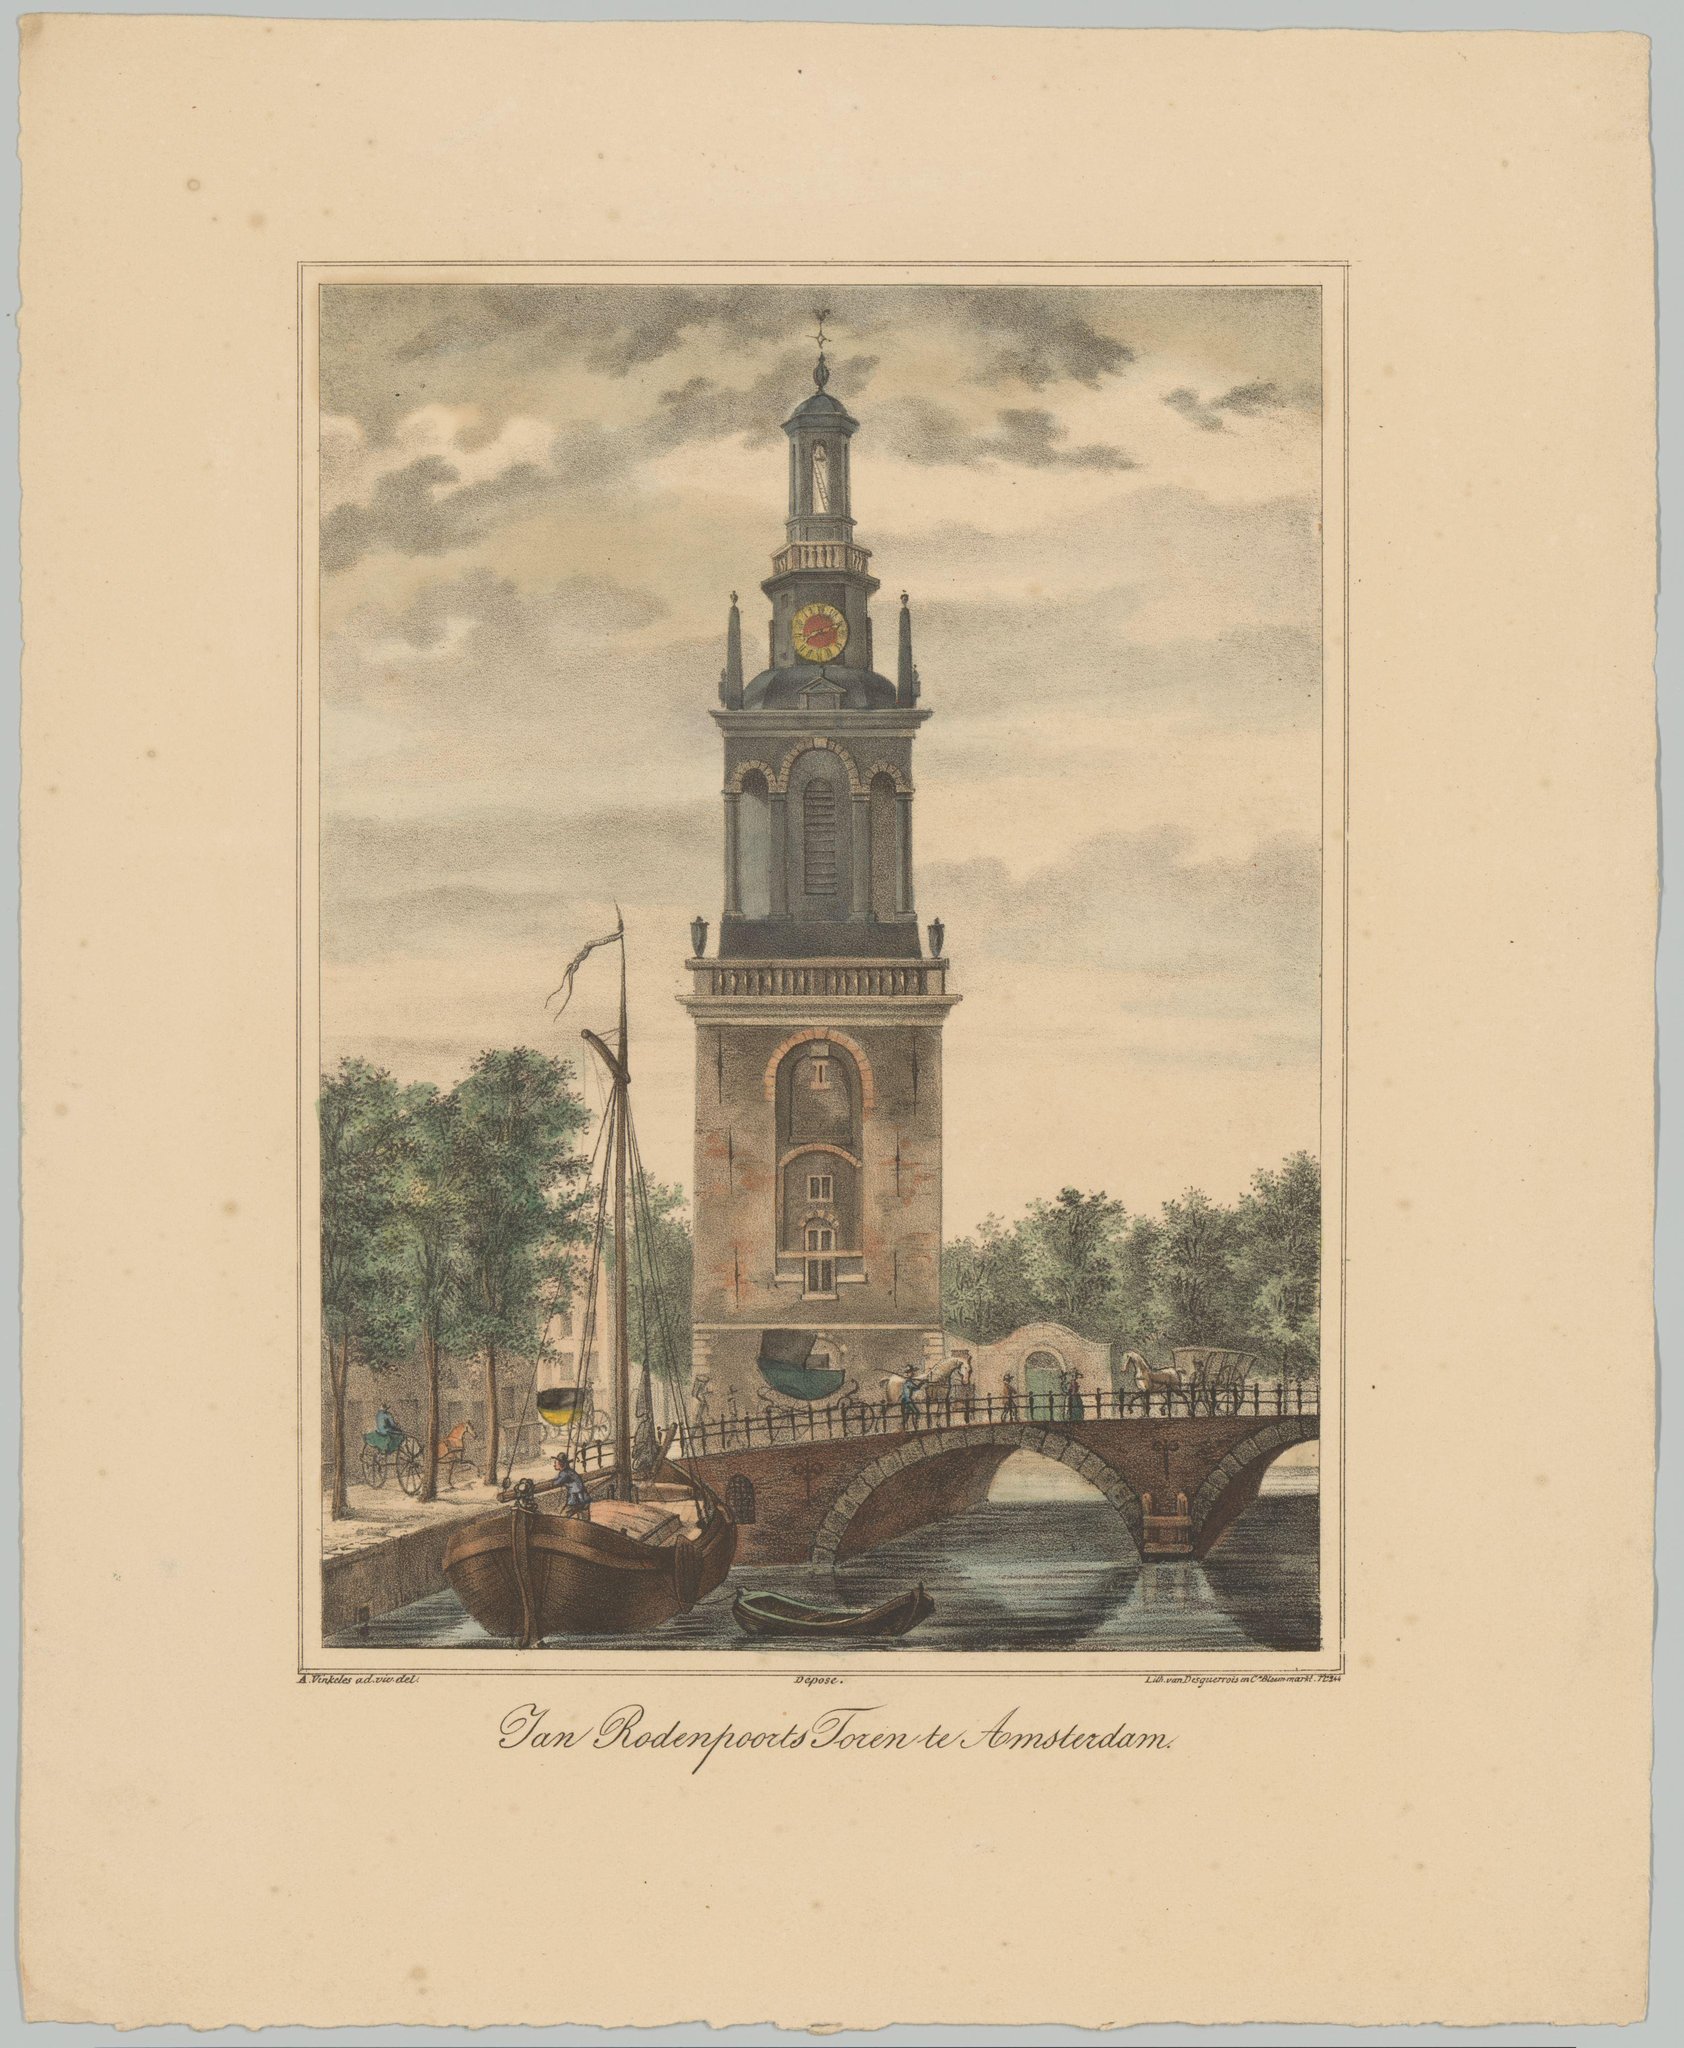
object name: print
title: Jan Rodenpoorts Toren te Amsterdam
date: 1828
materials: paper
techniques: hand coloring, lithograph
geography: amsterdam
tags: tower, clock tower ~ monumental adornment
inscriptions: : ‘Déposé.’, collector's mark: Lugt 2228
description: Onderdeel van een omslag met een serie van zes lithografieën van Amsterdamse torens.